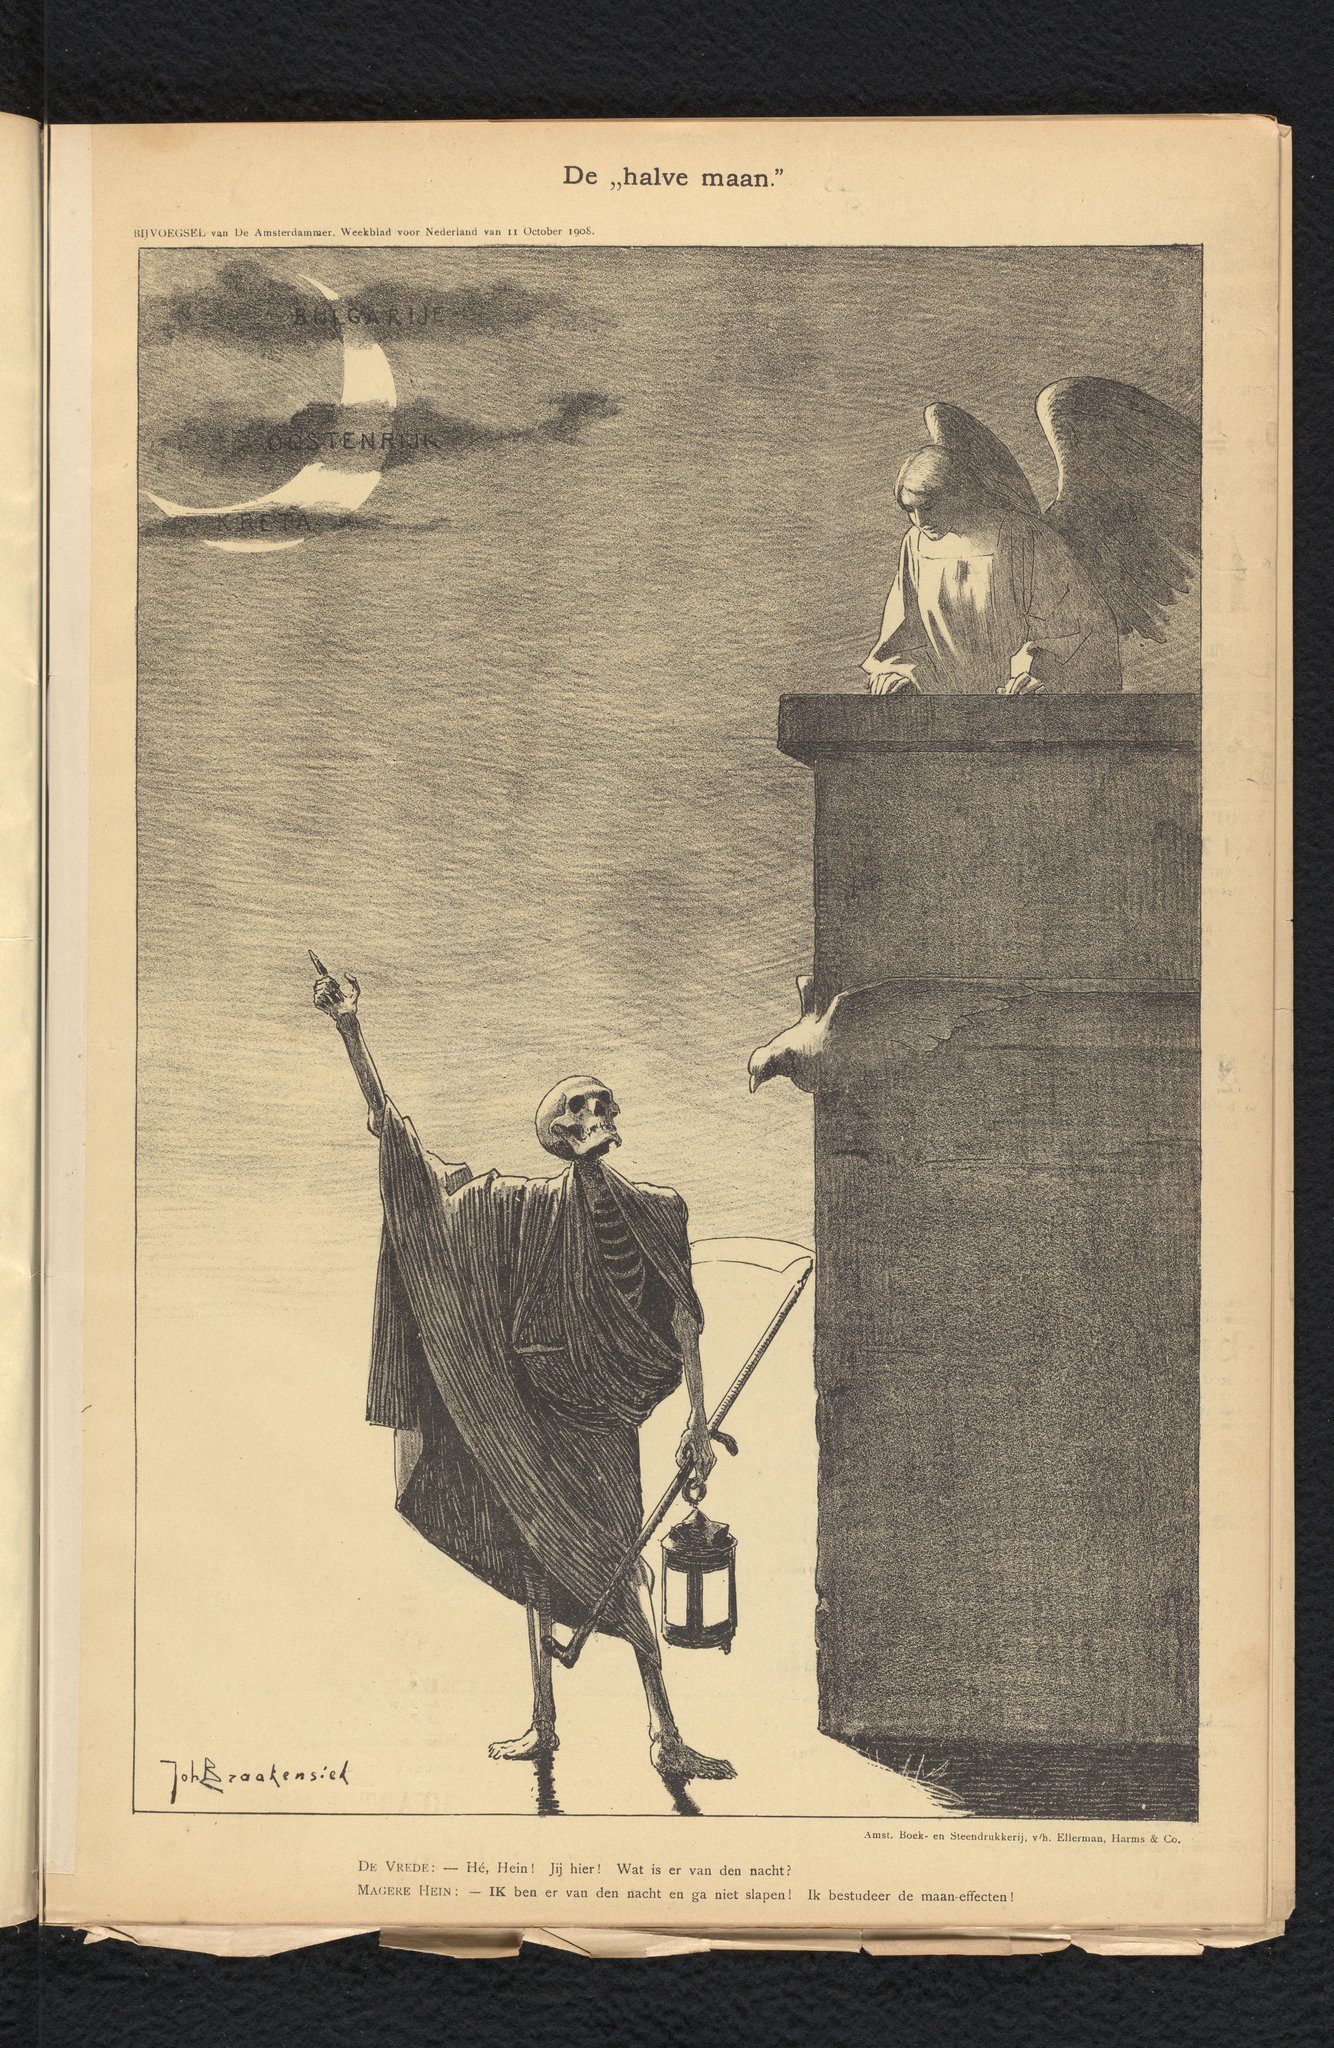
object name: cartoon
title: De "halve maan"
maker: johan braakensiek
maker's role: draughtsman, print maker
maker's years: 1858-1940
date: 1908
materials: paper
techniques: lithograph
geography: netherlands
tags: waxing moon, i.e. facing this way: ), symbols, allegories of peace, 'pax'; 'pace' (ripa), death as skeleton, political caricatures and satires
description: De Dood wijst de engel van de Vrede op de wolken die de maan verduisteren. Naar aanleiding van de spanningen tussen Turkije (de halve maan) en Bulgarije, Oostenrijk en Kreta.